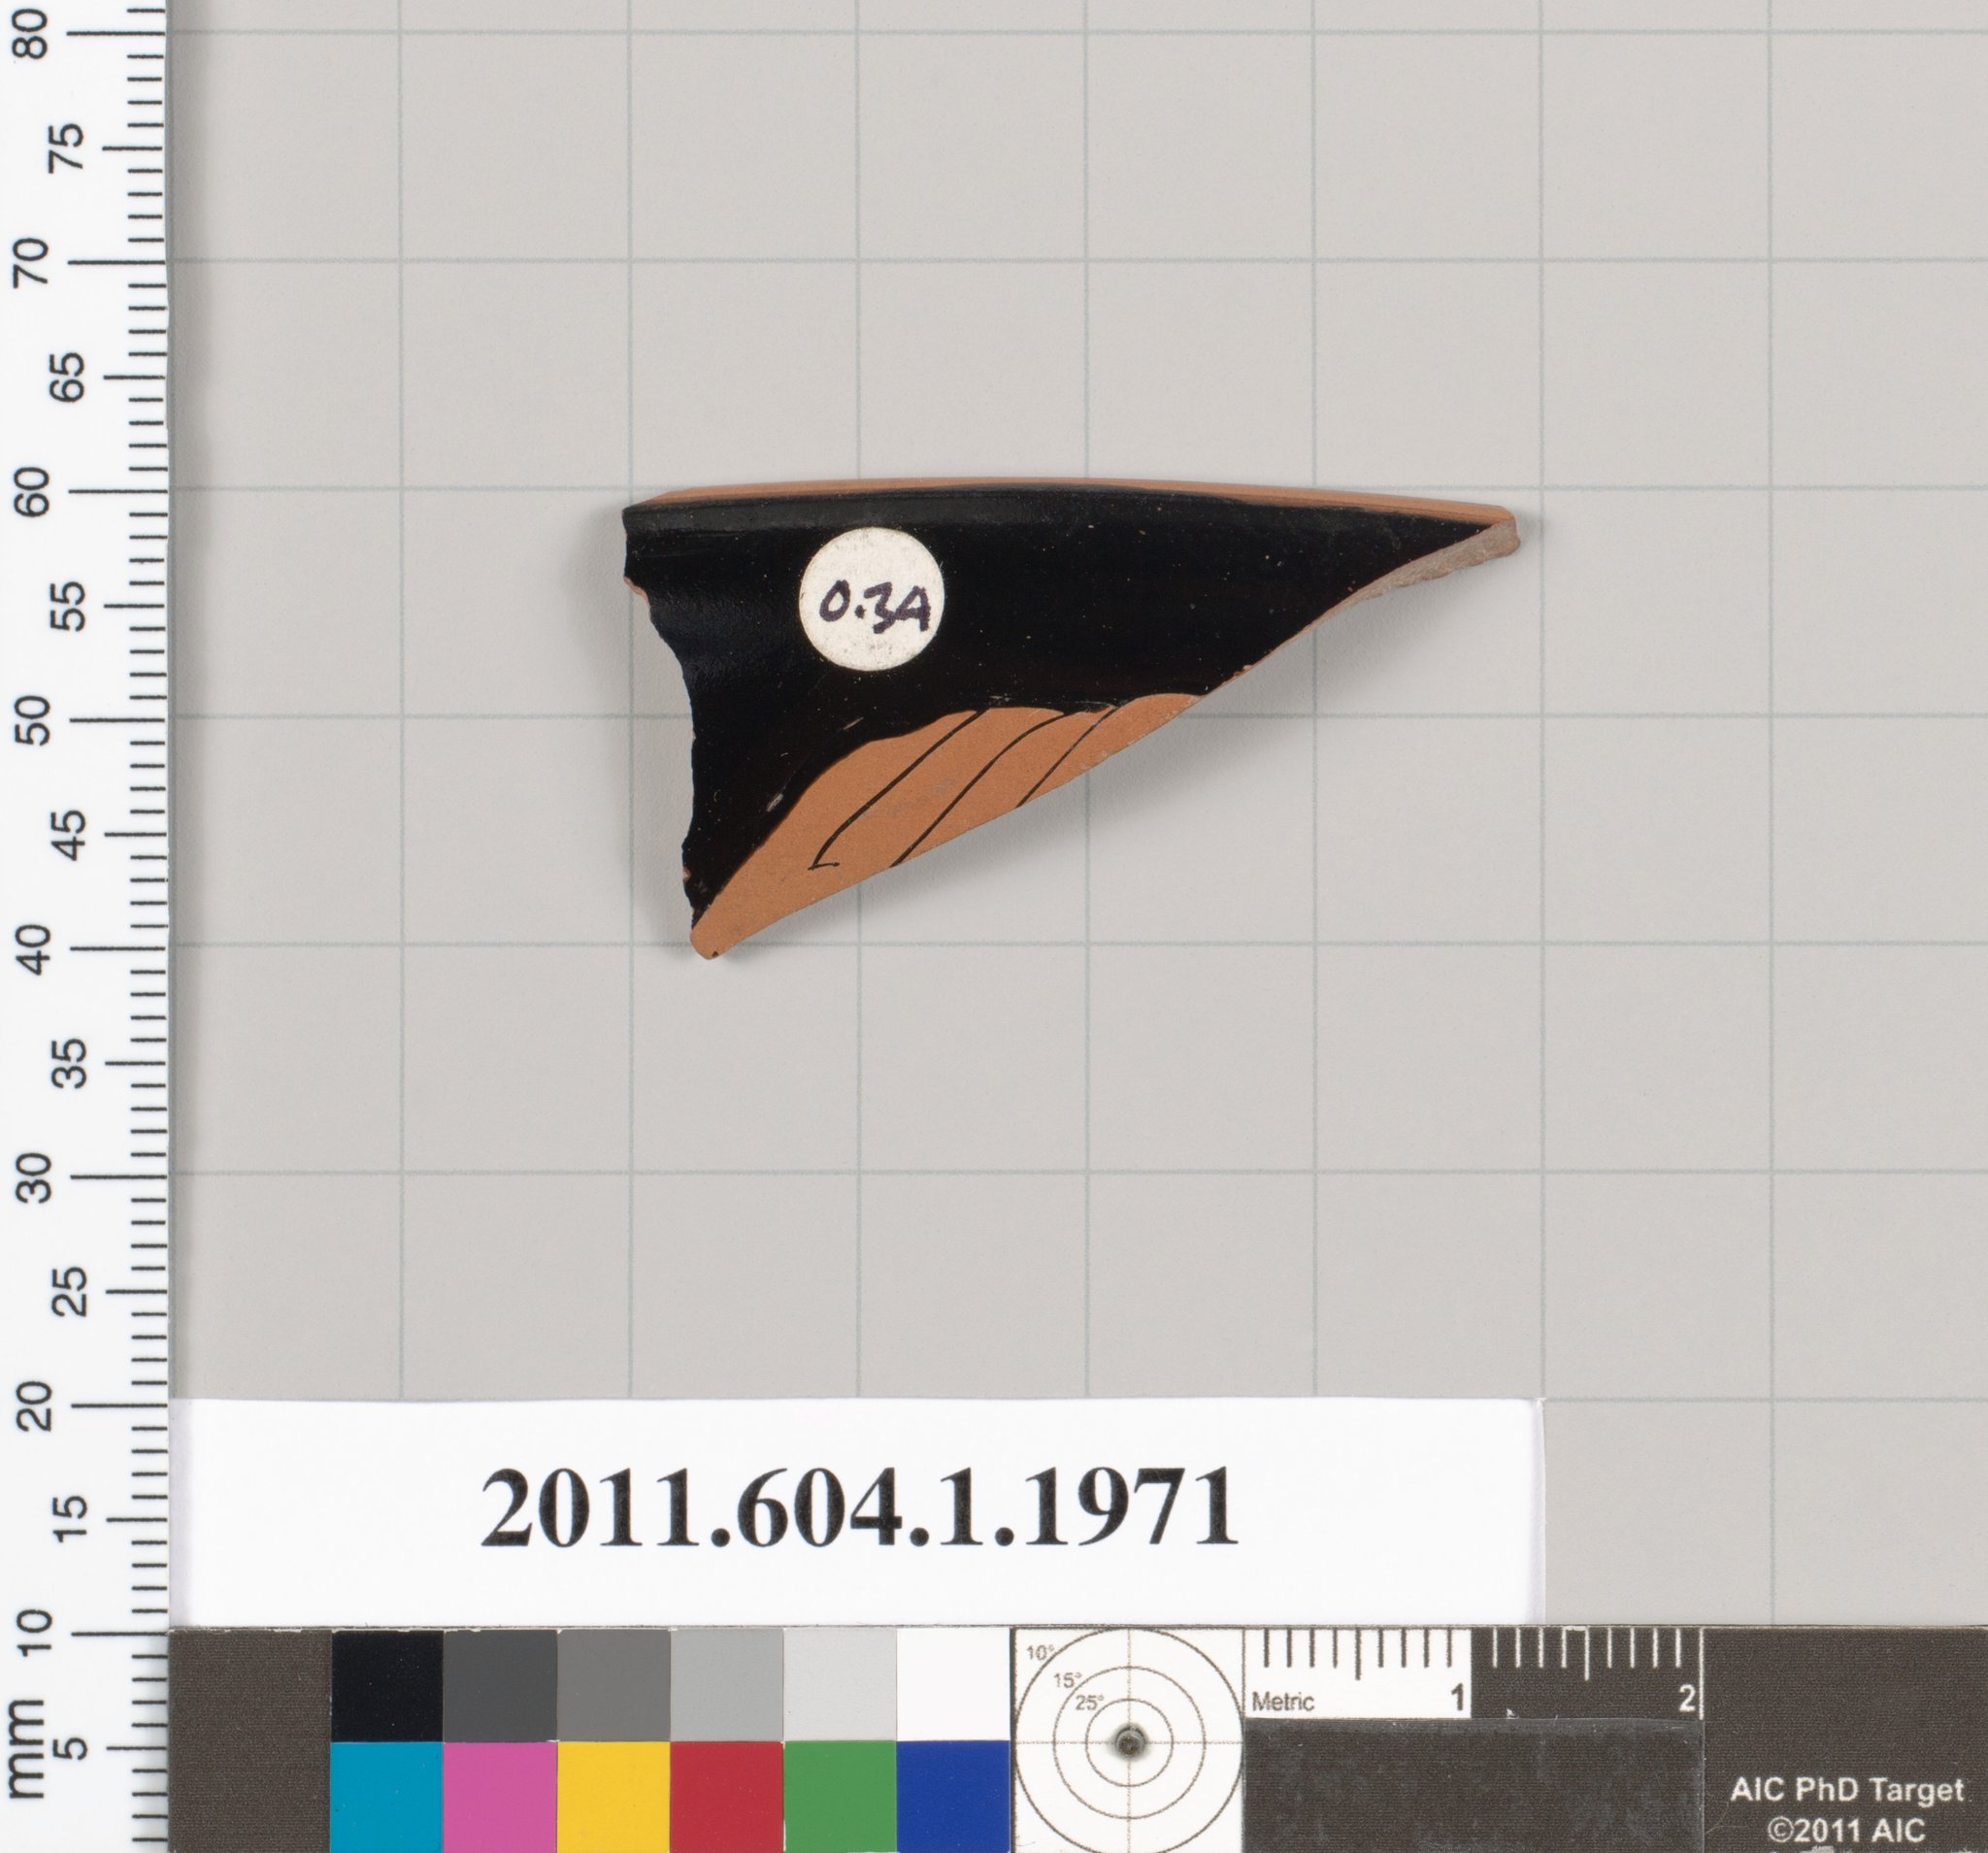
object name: kylix fragment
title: Terracotta rim fragment of a kylix (drinking cup)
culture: greek, attic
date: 475-451 BCE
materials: terracotta